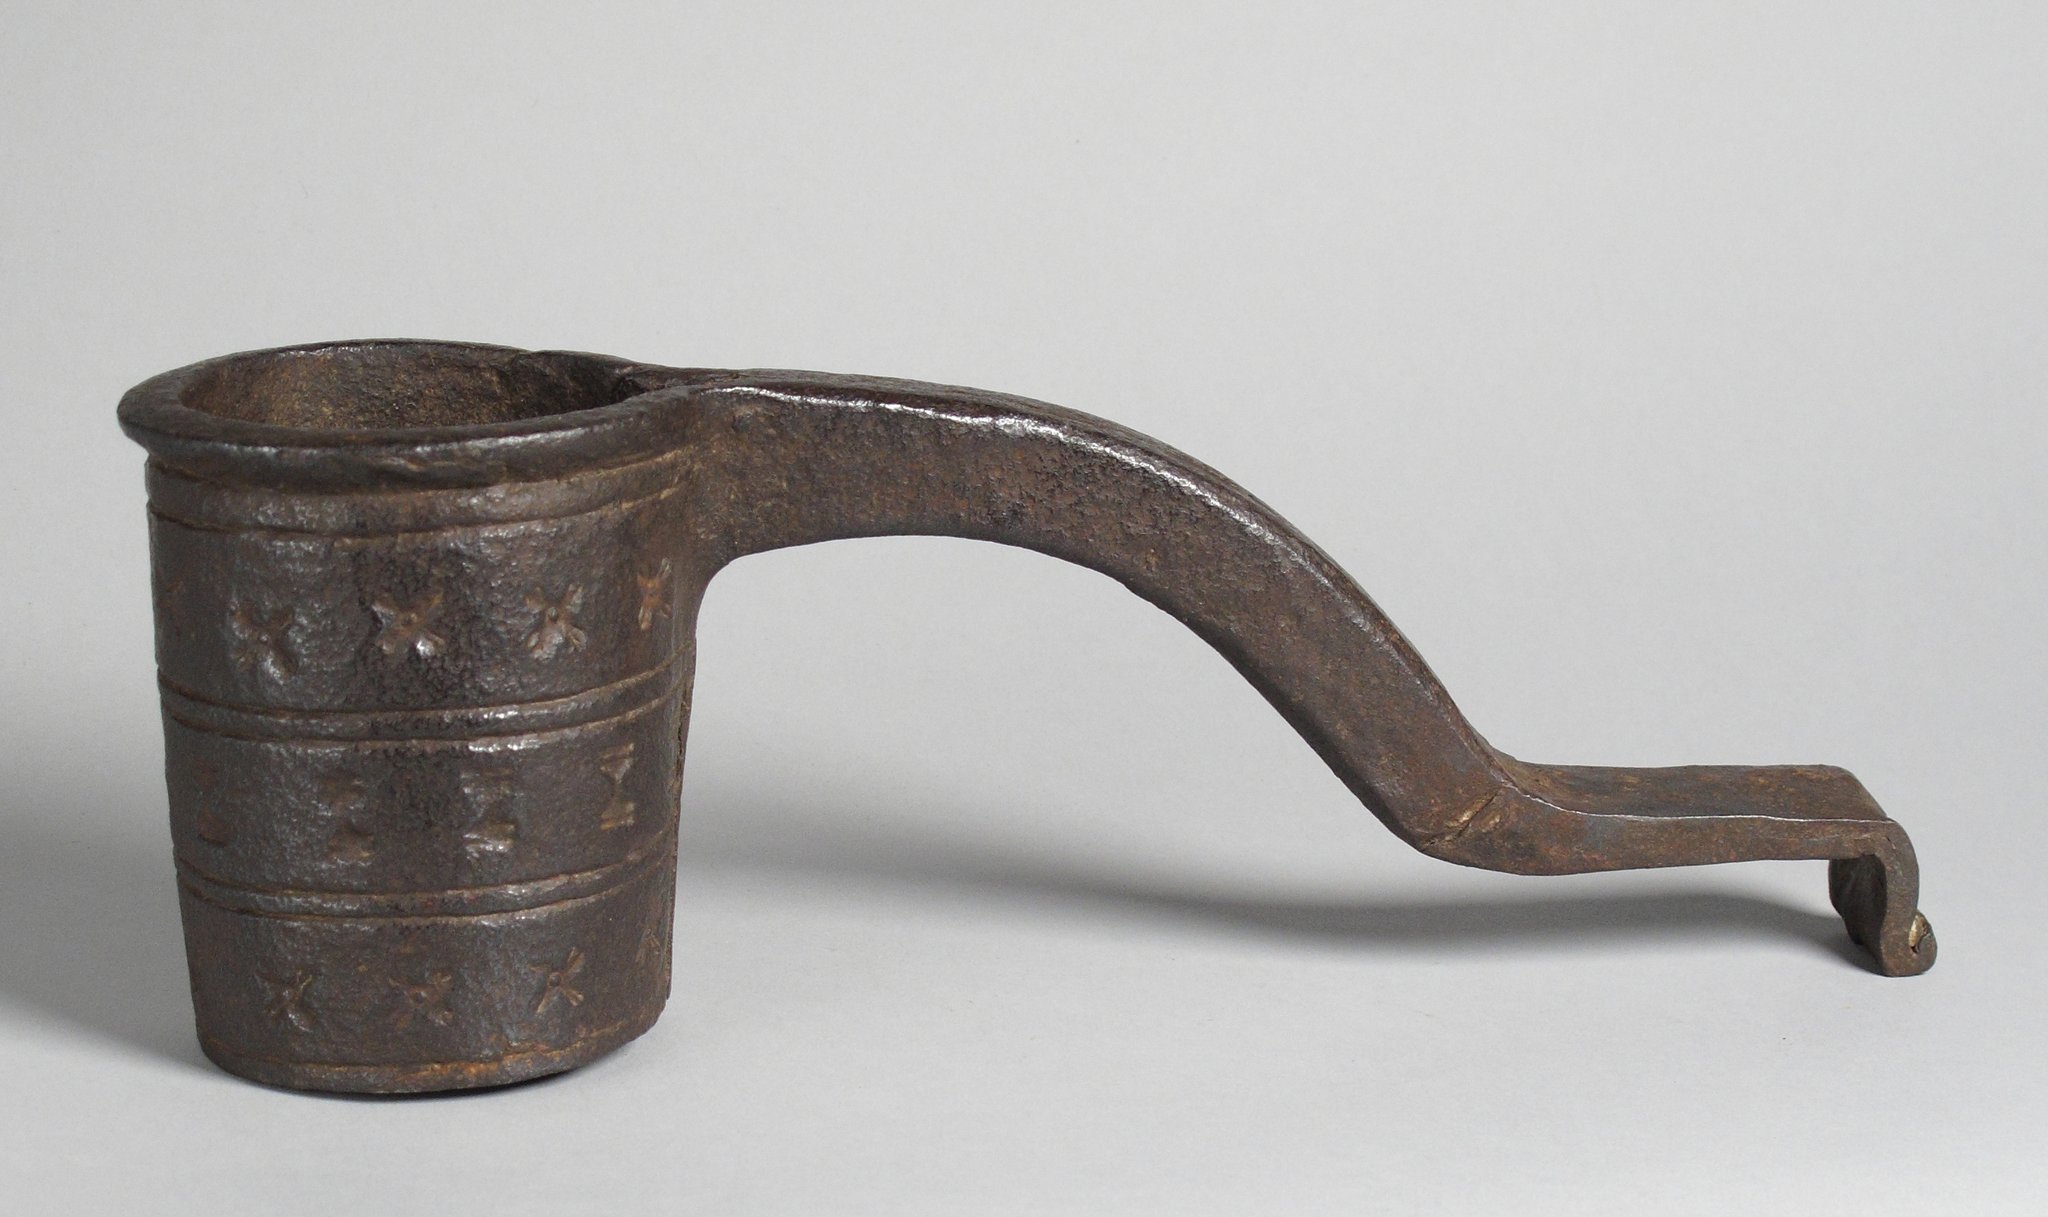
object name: torch holder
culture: european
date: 1401-1600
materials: iron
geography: austria